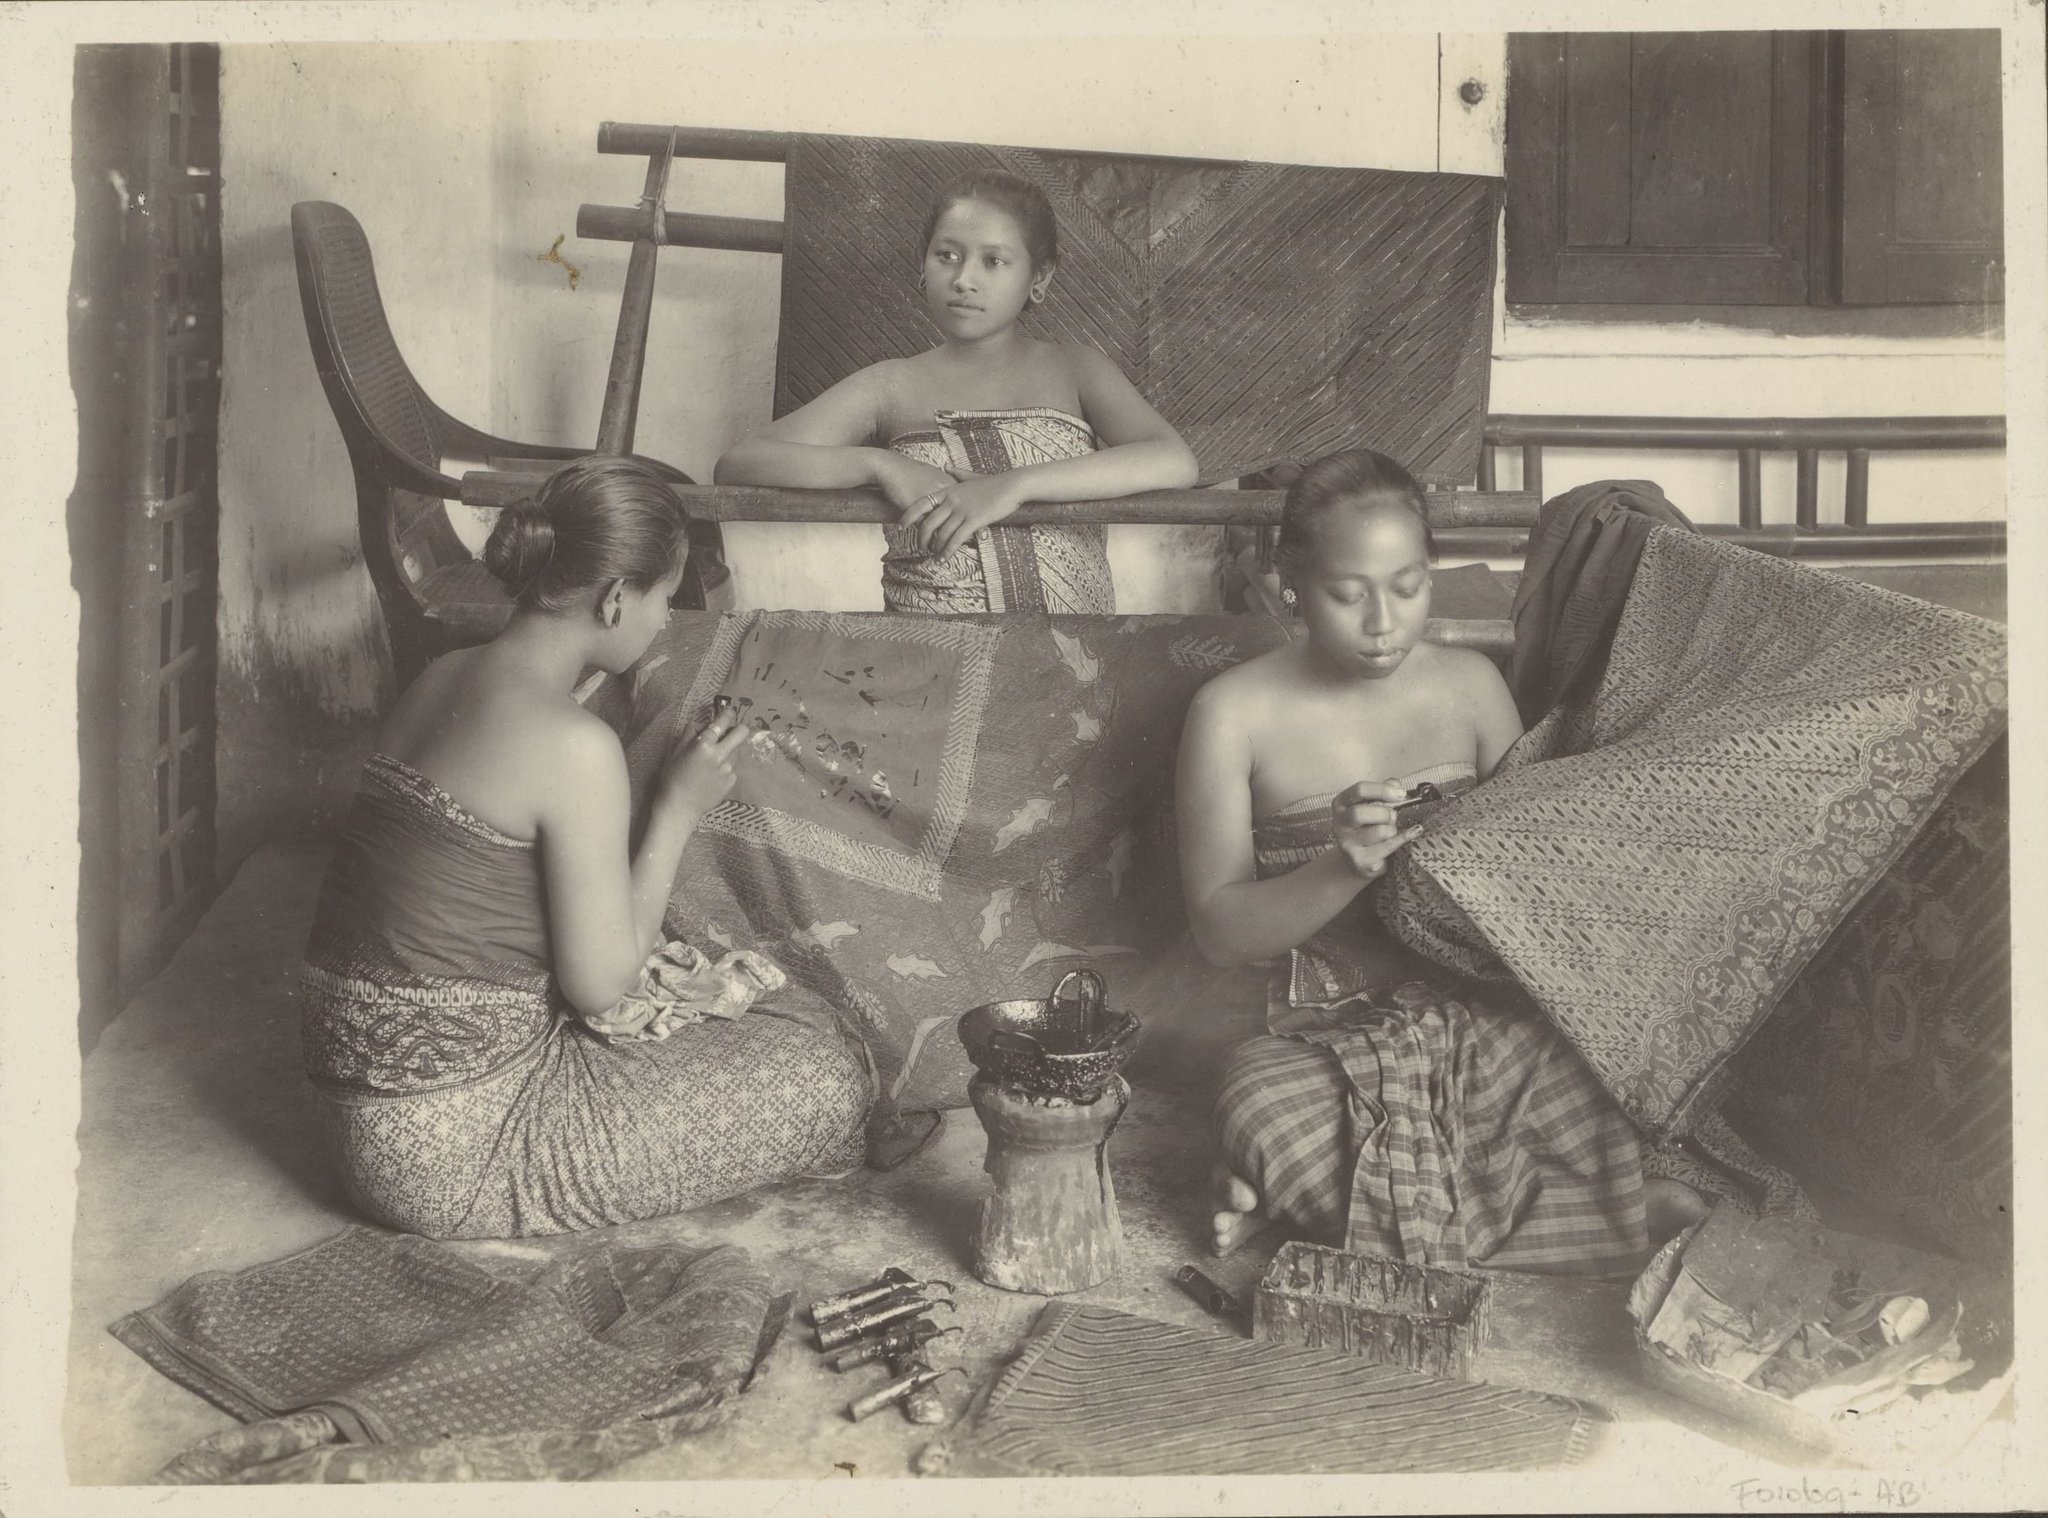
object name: photograph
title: Drie batikkende Indische vrouwen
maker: onnes kurkdjian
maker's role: fotograaf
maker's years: 1851-1903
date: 1912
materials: paper, photographic support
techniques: gelatin silver print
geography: dutch east indies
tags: dyeing of cloth with pattern; batik-work, dutch east indies, the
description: Onderdeel van Reisalbum met veertig foto's van Nederlands-Indië.